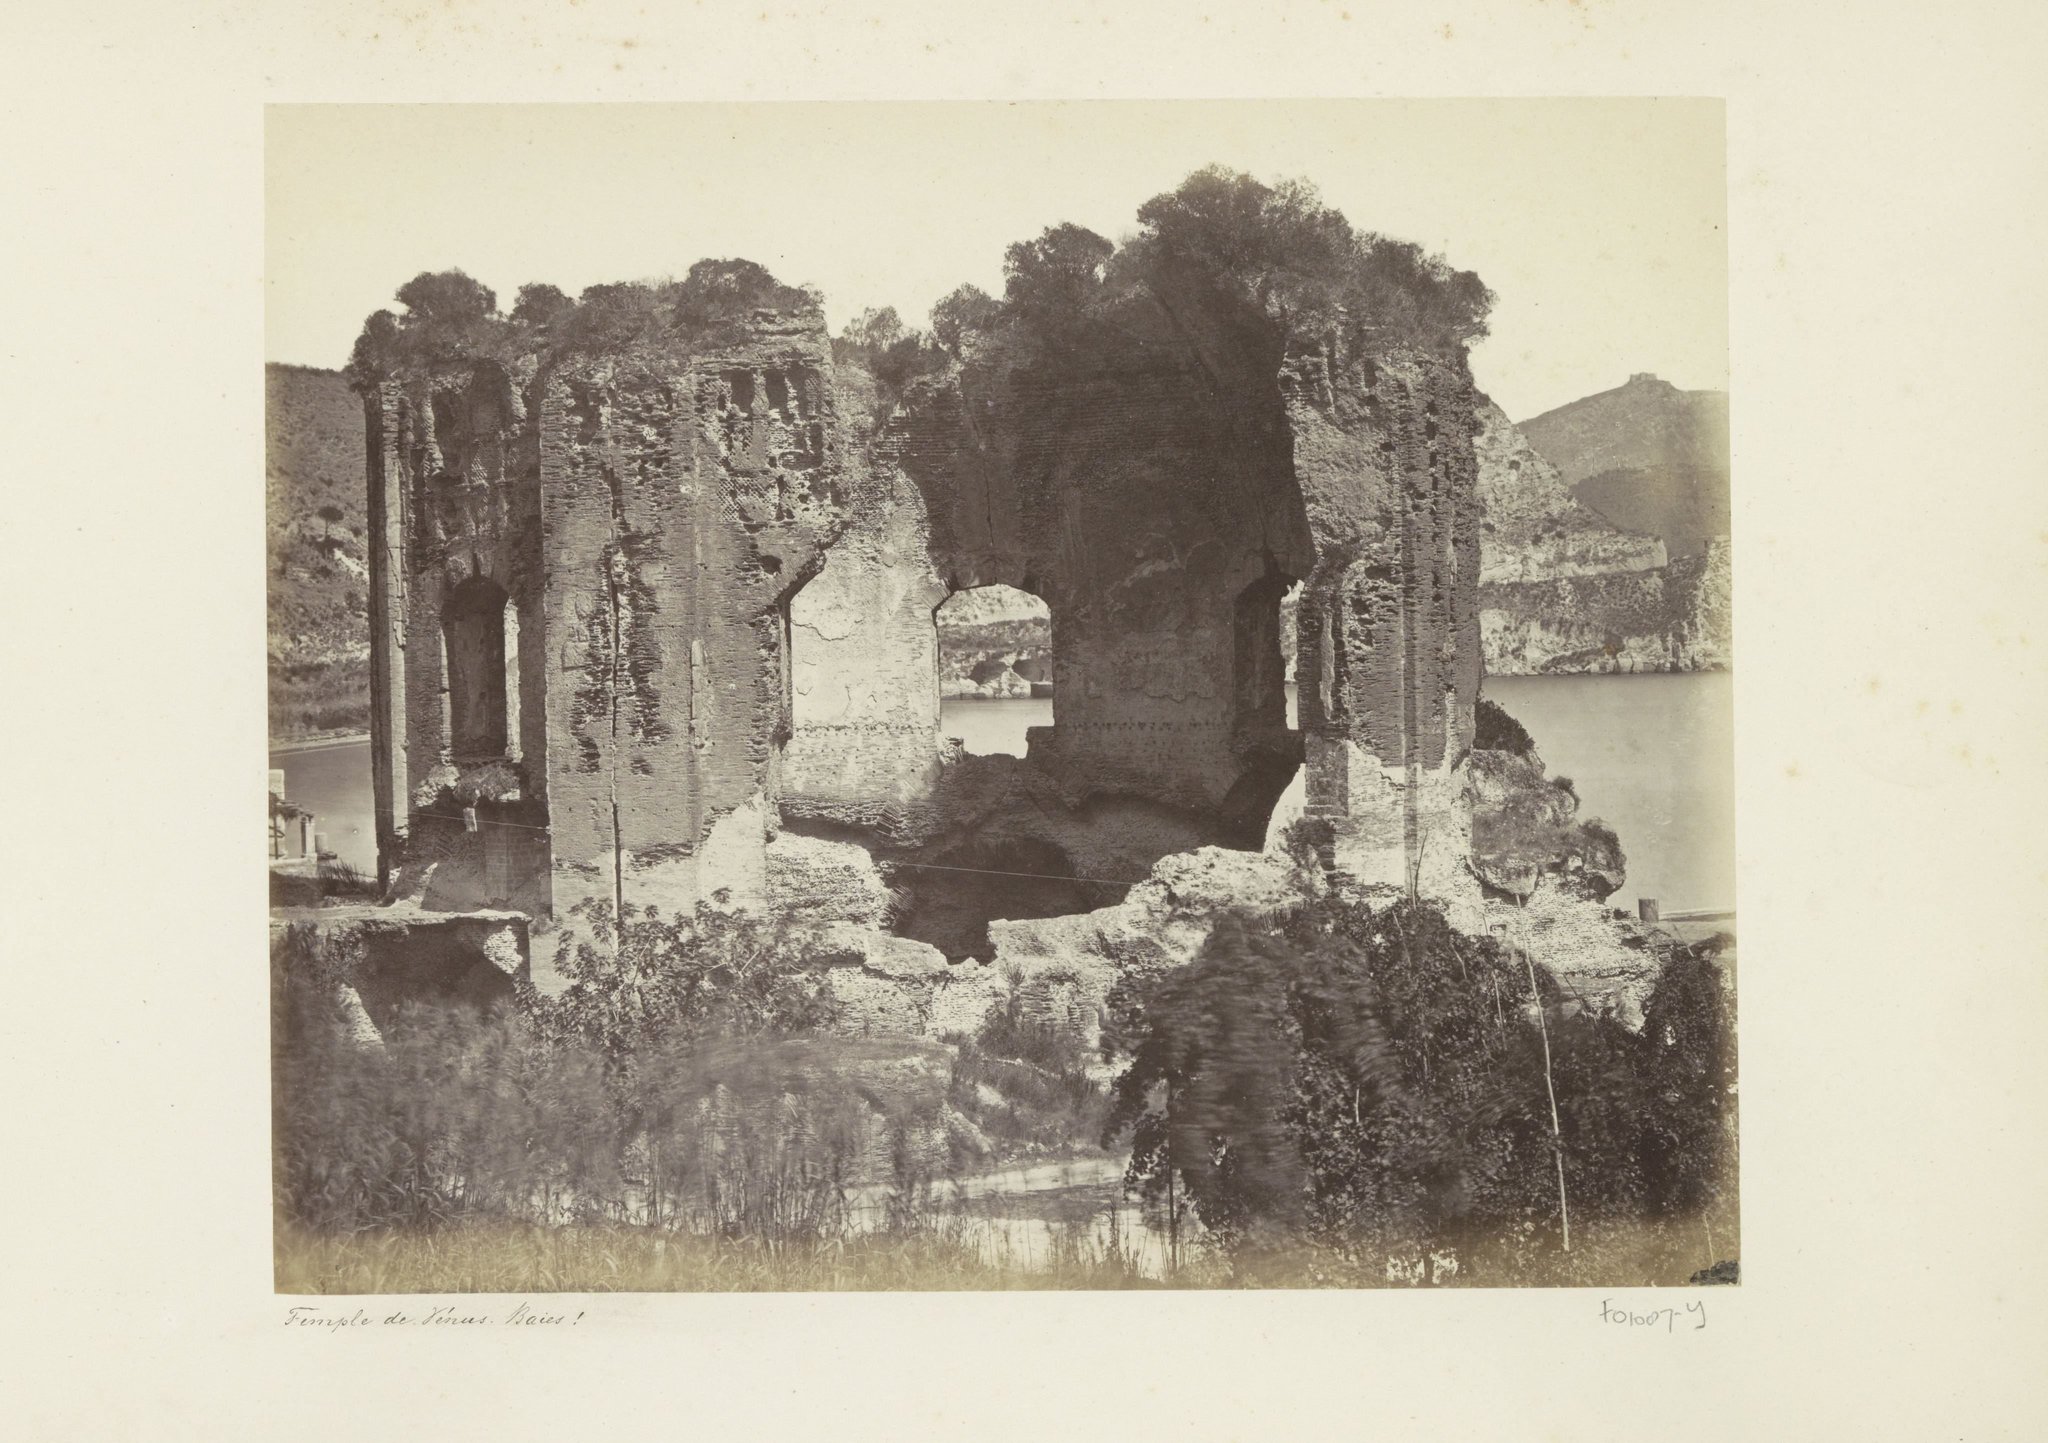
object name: photograph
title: Ruïne van de Tempel van Venus in Baia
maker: Anonymous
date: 1865-1875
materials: paper, photographic support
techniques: albumen print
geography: baia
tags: temple, shrine ~ non-christian religions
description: Onderdeel van Reisalbum met foto's van bezienswaardigheden in Napels en omgeving.